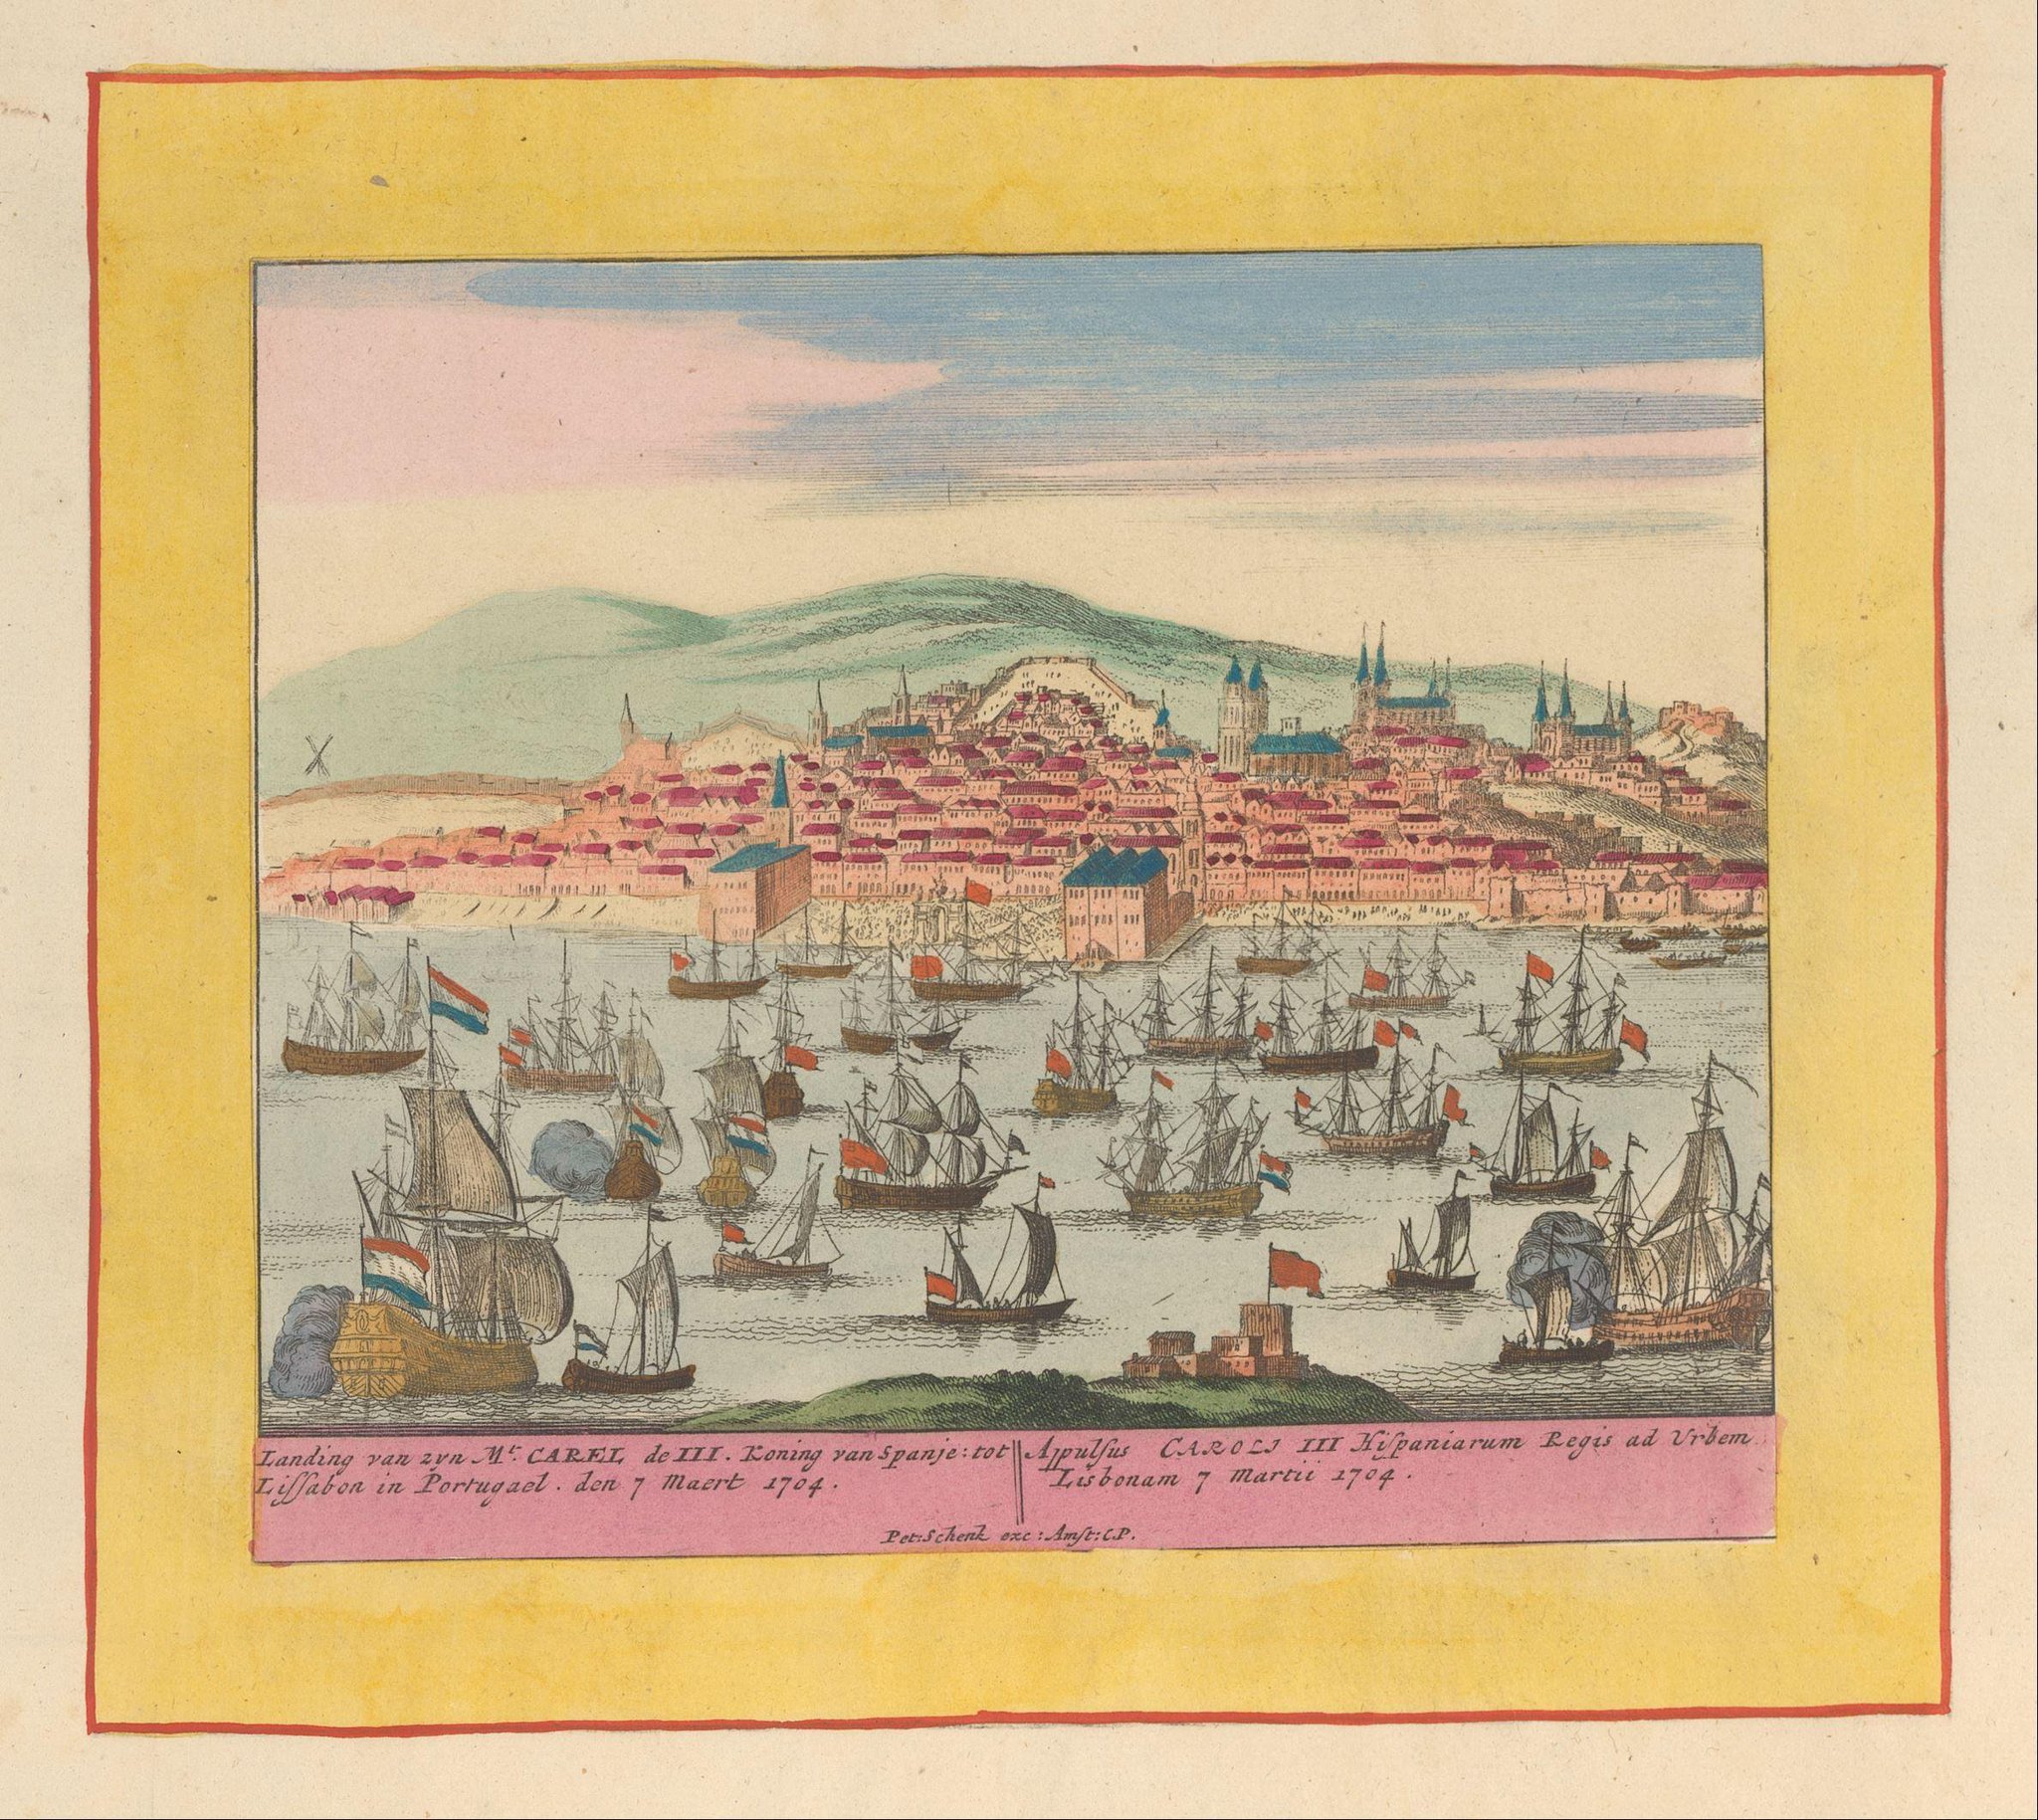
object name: book illustration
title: Schouwburg van den Oorlog, Beginnende van Koning Karel den II. Tot op Koning Karel den III. Bestaande in IX. Historische Figuren op een Olifants Blad, als Veldslagen, Belegeringen te Water en te Lande, met de voornaamste Vestingen (...)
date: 1707-1720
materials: paper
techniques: etching, hand coloring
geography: amsterdam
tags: vienna, charles vi (holy roman emperor), city-view in general; 'veduta'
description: Aankomst van de Hollands-Engelse vloot met aan boord koning Karel III (aartshertog Karel van Oostenrijk) te Lissabon, 7 maart 1704. Gezicht op Lissabon met de schepen van de vloot op de rivier de Taag voor de stad. Onder de voorstelling een toelichting in het Nederlands en Latijn. Prent maakt deel uit van een album.